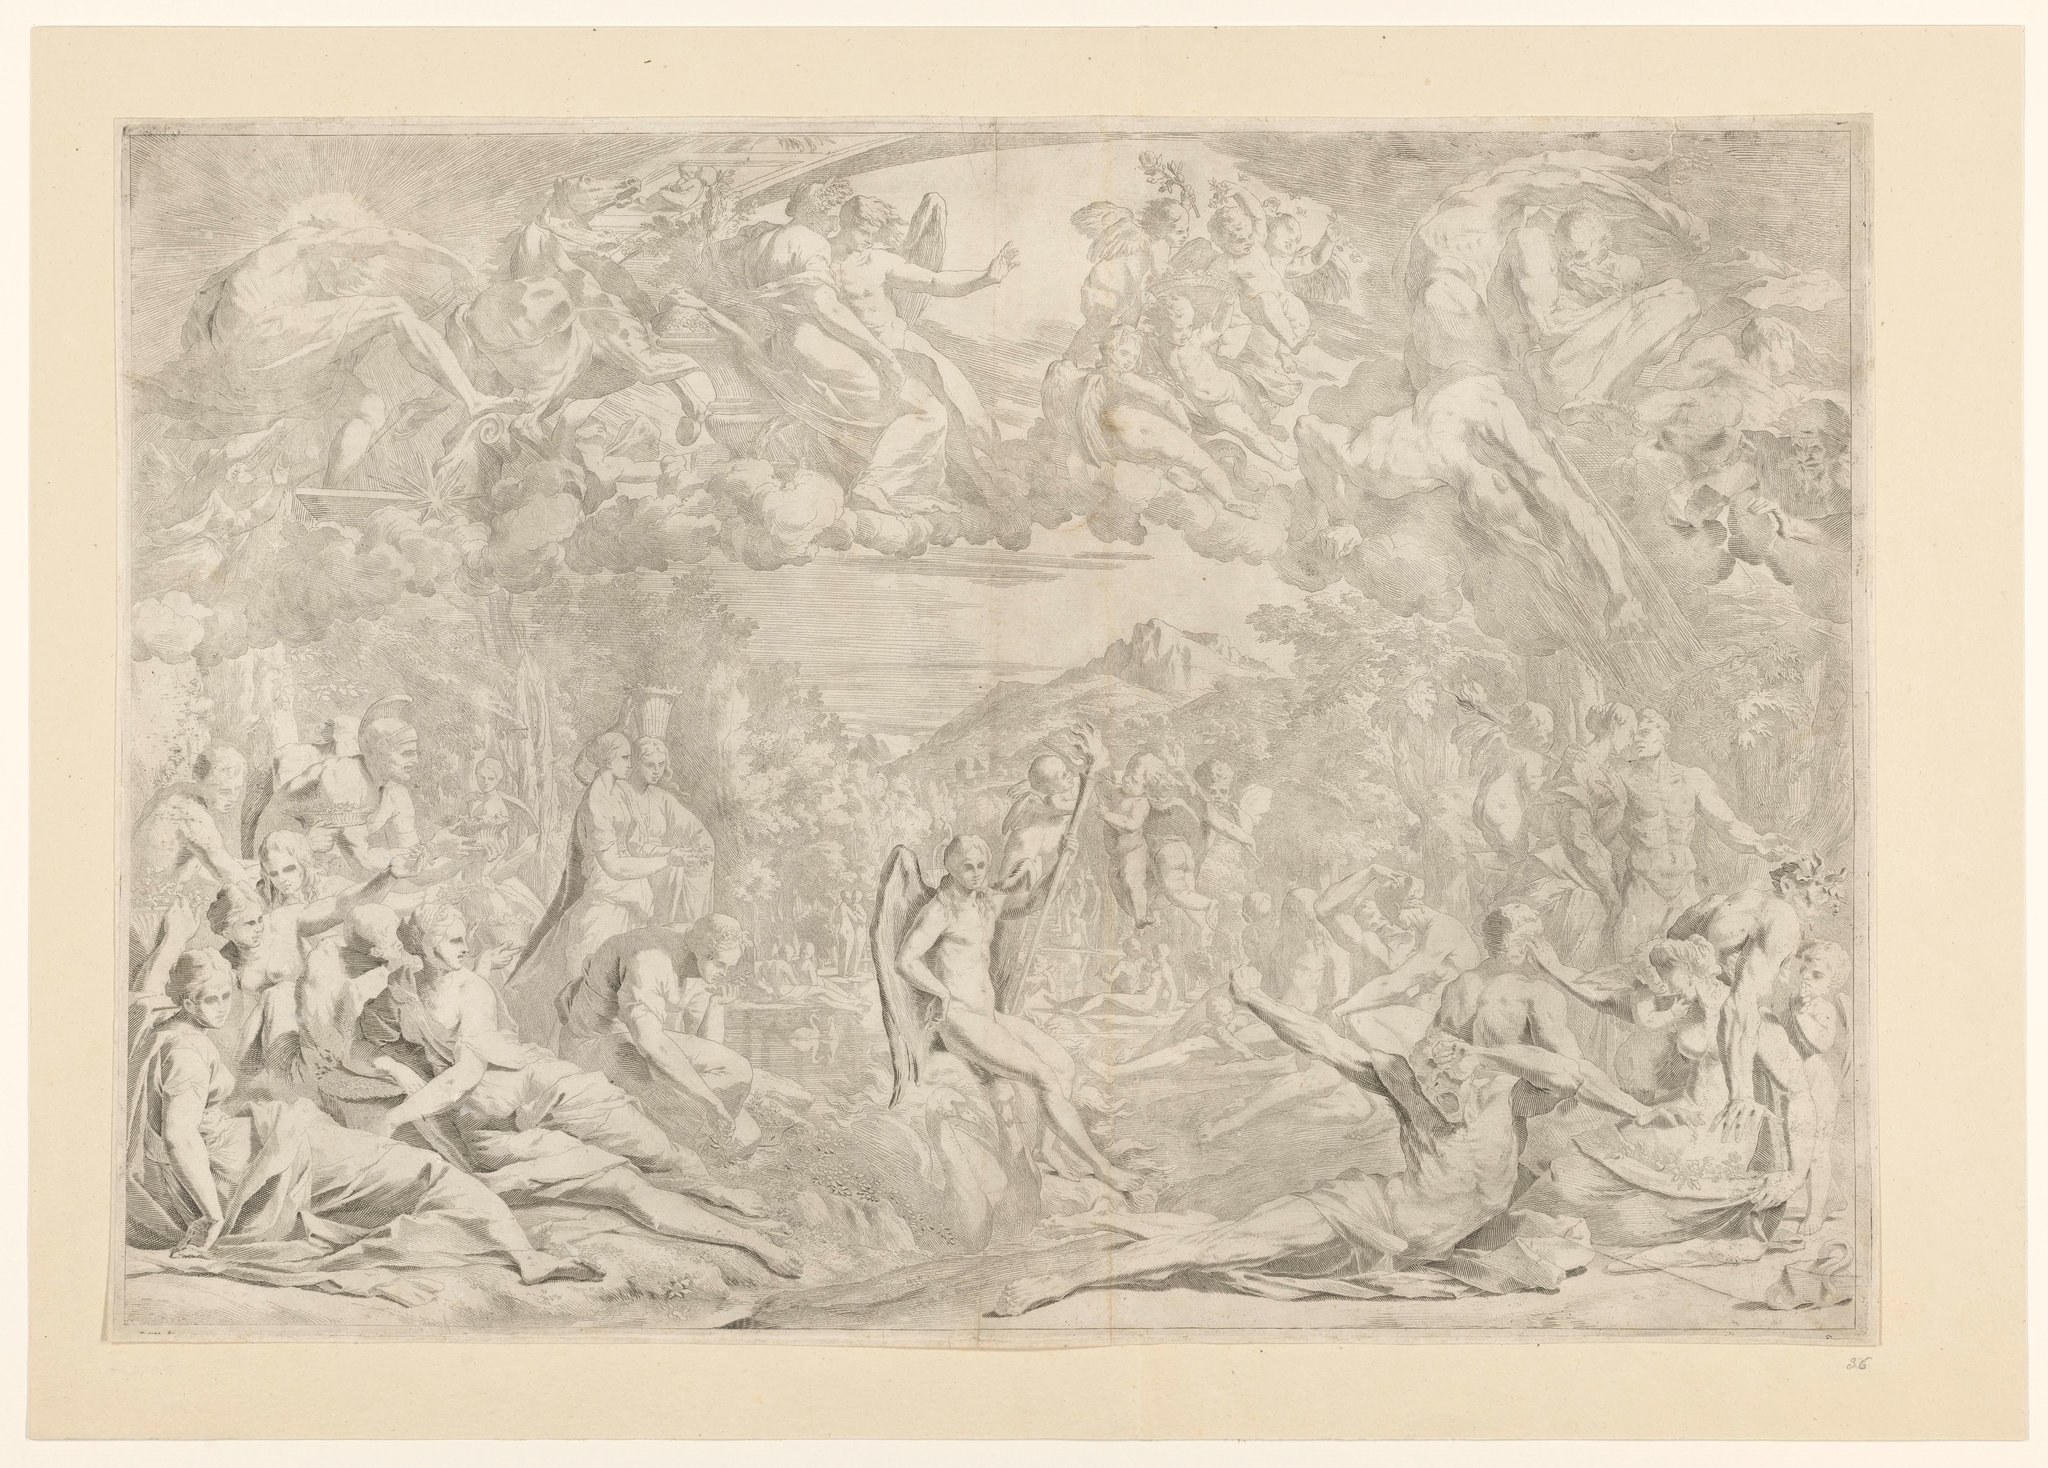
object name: print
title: Allegorie van de Lente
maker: pietro testa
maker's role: draughtsman, painter, print maker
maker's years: 1611-1650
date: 1621-1650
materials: paper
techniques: engraving, etching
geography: italy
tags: the chariot of the sun, (story of) apollo (phoebus), spring, 'ver'; 'primavera' (ripa), (story of) venus (aphrodite), couple of lovers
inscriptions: collector's mark: Lugt 240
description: Allegorische voorstelling van het seizoen lente. De zon, weergegeven als de god Apollo op zijn zonnewagen, zweeft linksboven. Naast de wagen zweven Venus en Amor op wolken. Recht een groep putti. Op de grond een gevleugelde figuur, zittend op een bal van vuur, voortgetrokken door twee zwanen over water. Rond het water verschillende personificaties van bloemen en verliefde paren.